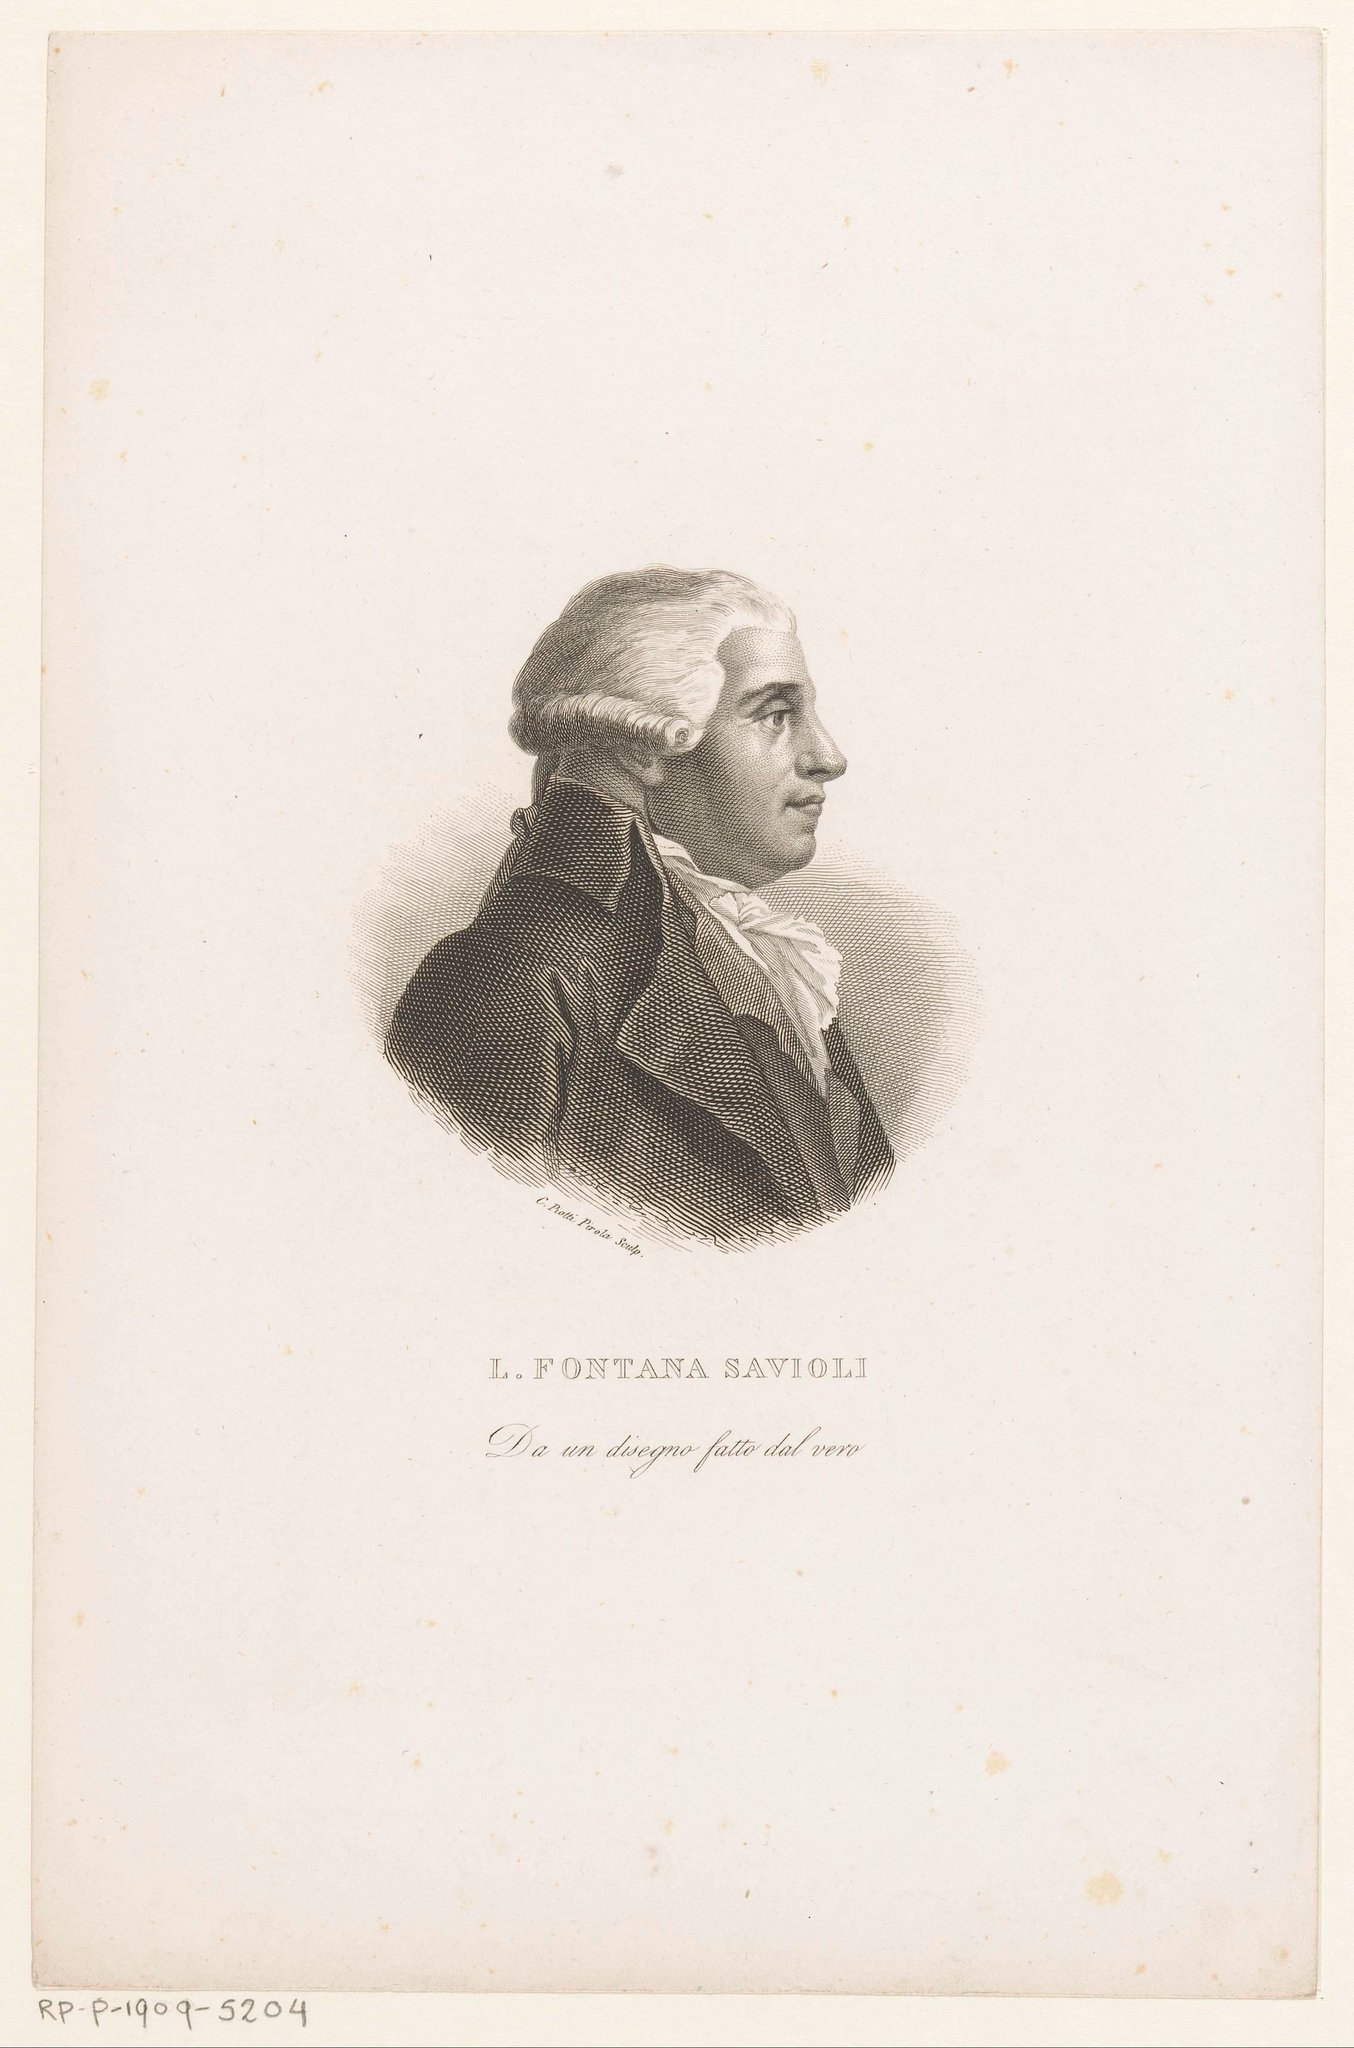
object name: print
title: Portret van dichter en historicus Ludovico Savioli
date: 1810-1900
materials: paper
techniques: engraving, etching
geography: italy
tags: historical persons, writer, poet, author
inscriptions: collector's mark: Lugt 2228